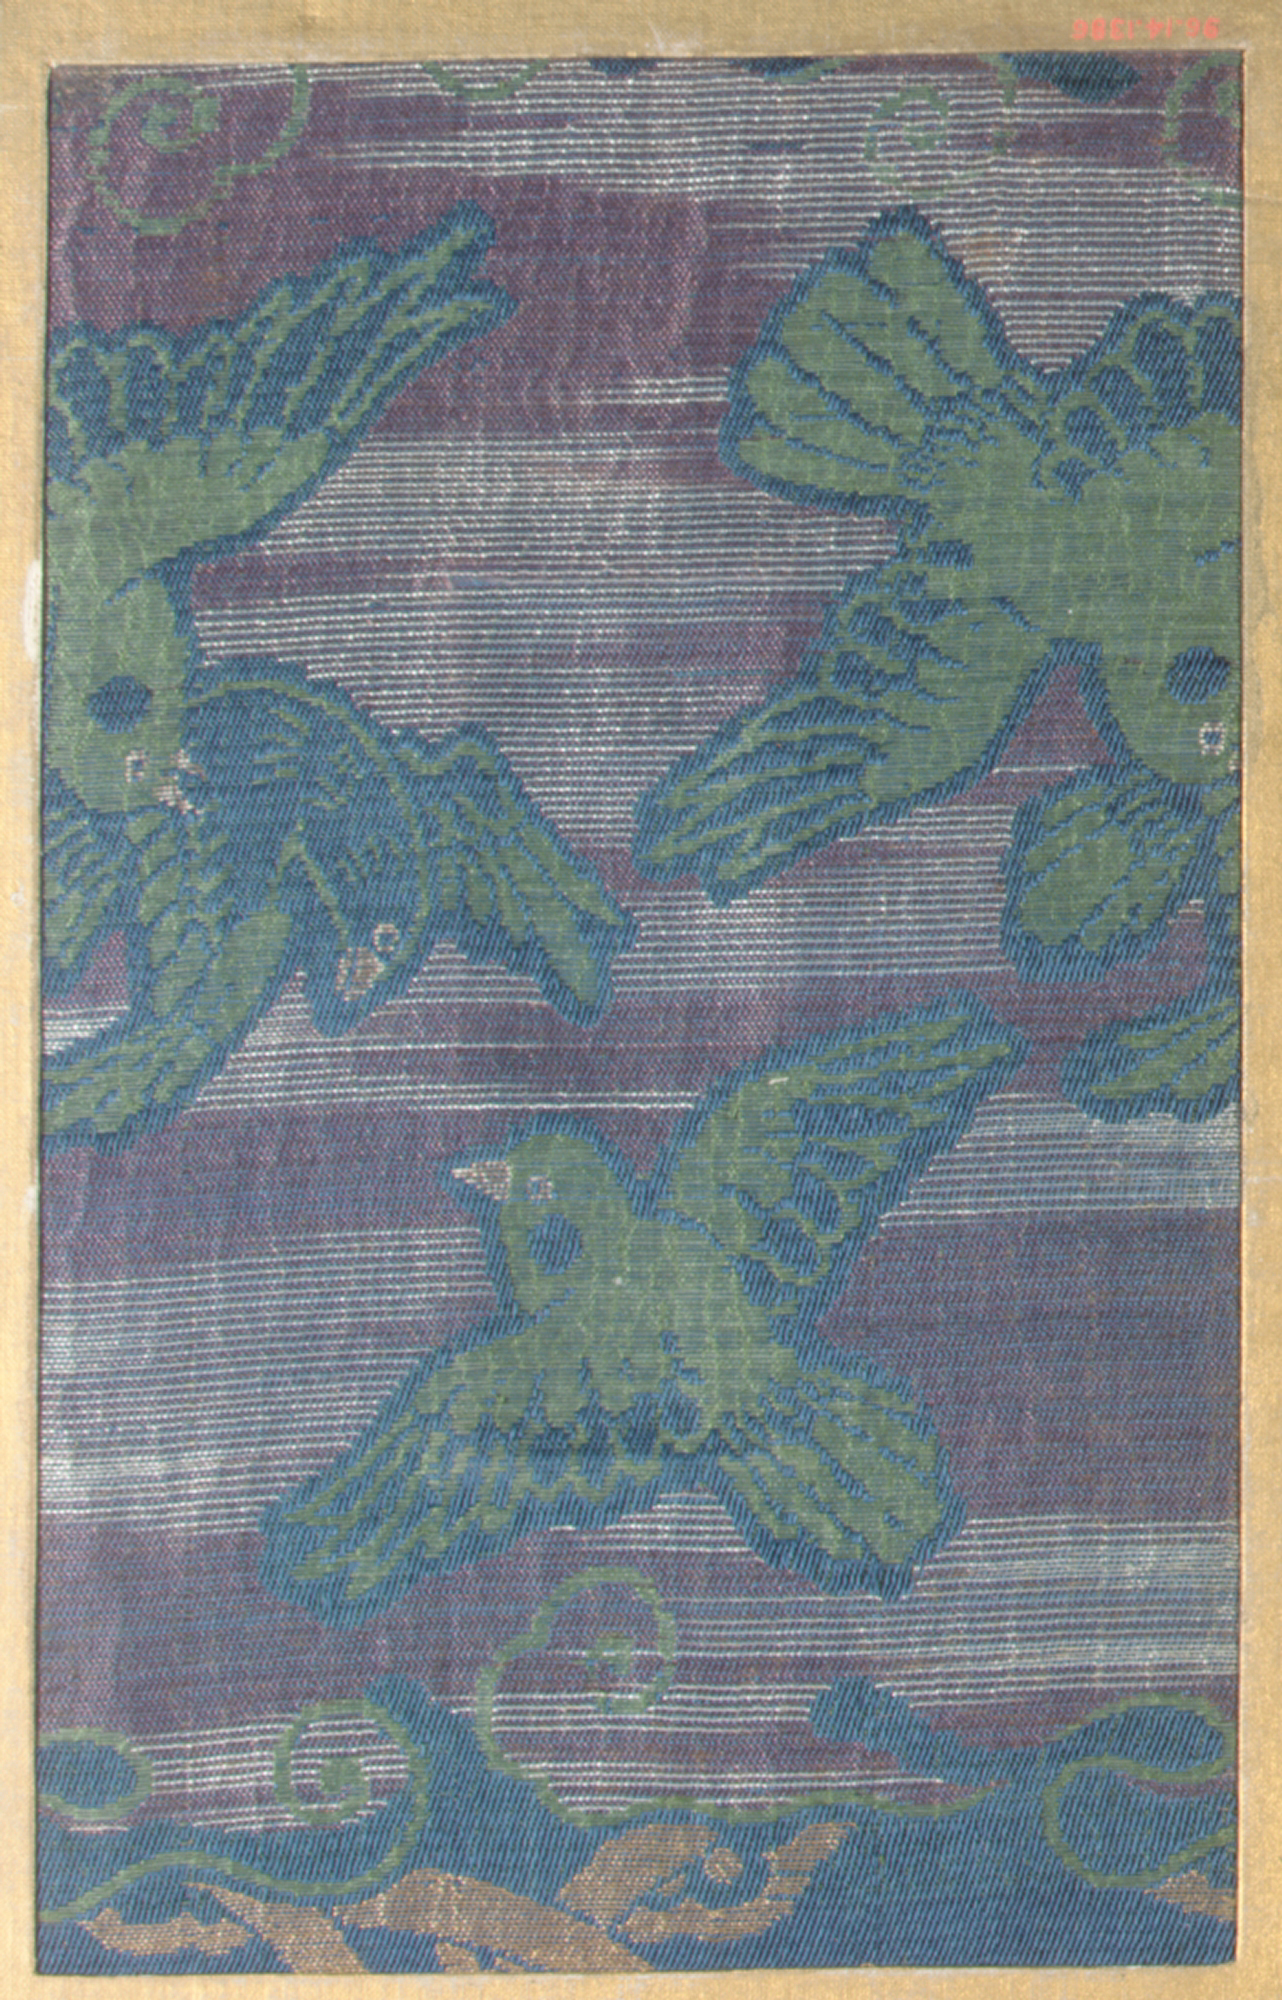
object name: piece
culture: japanese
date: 1701-1900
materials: silk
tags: birds